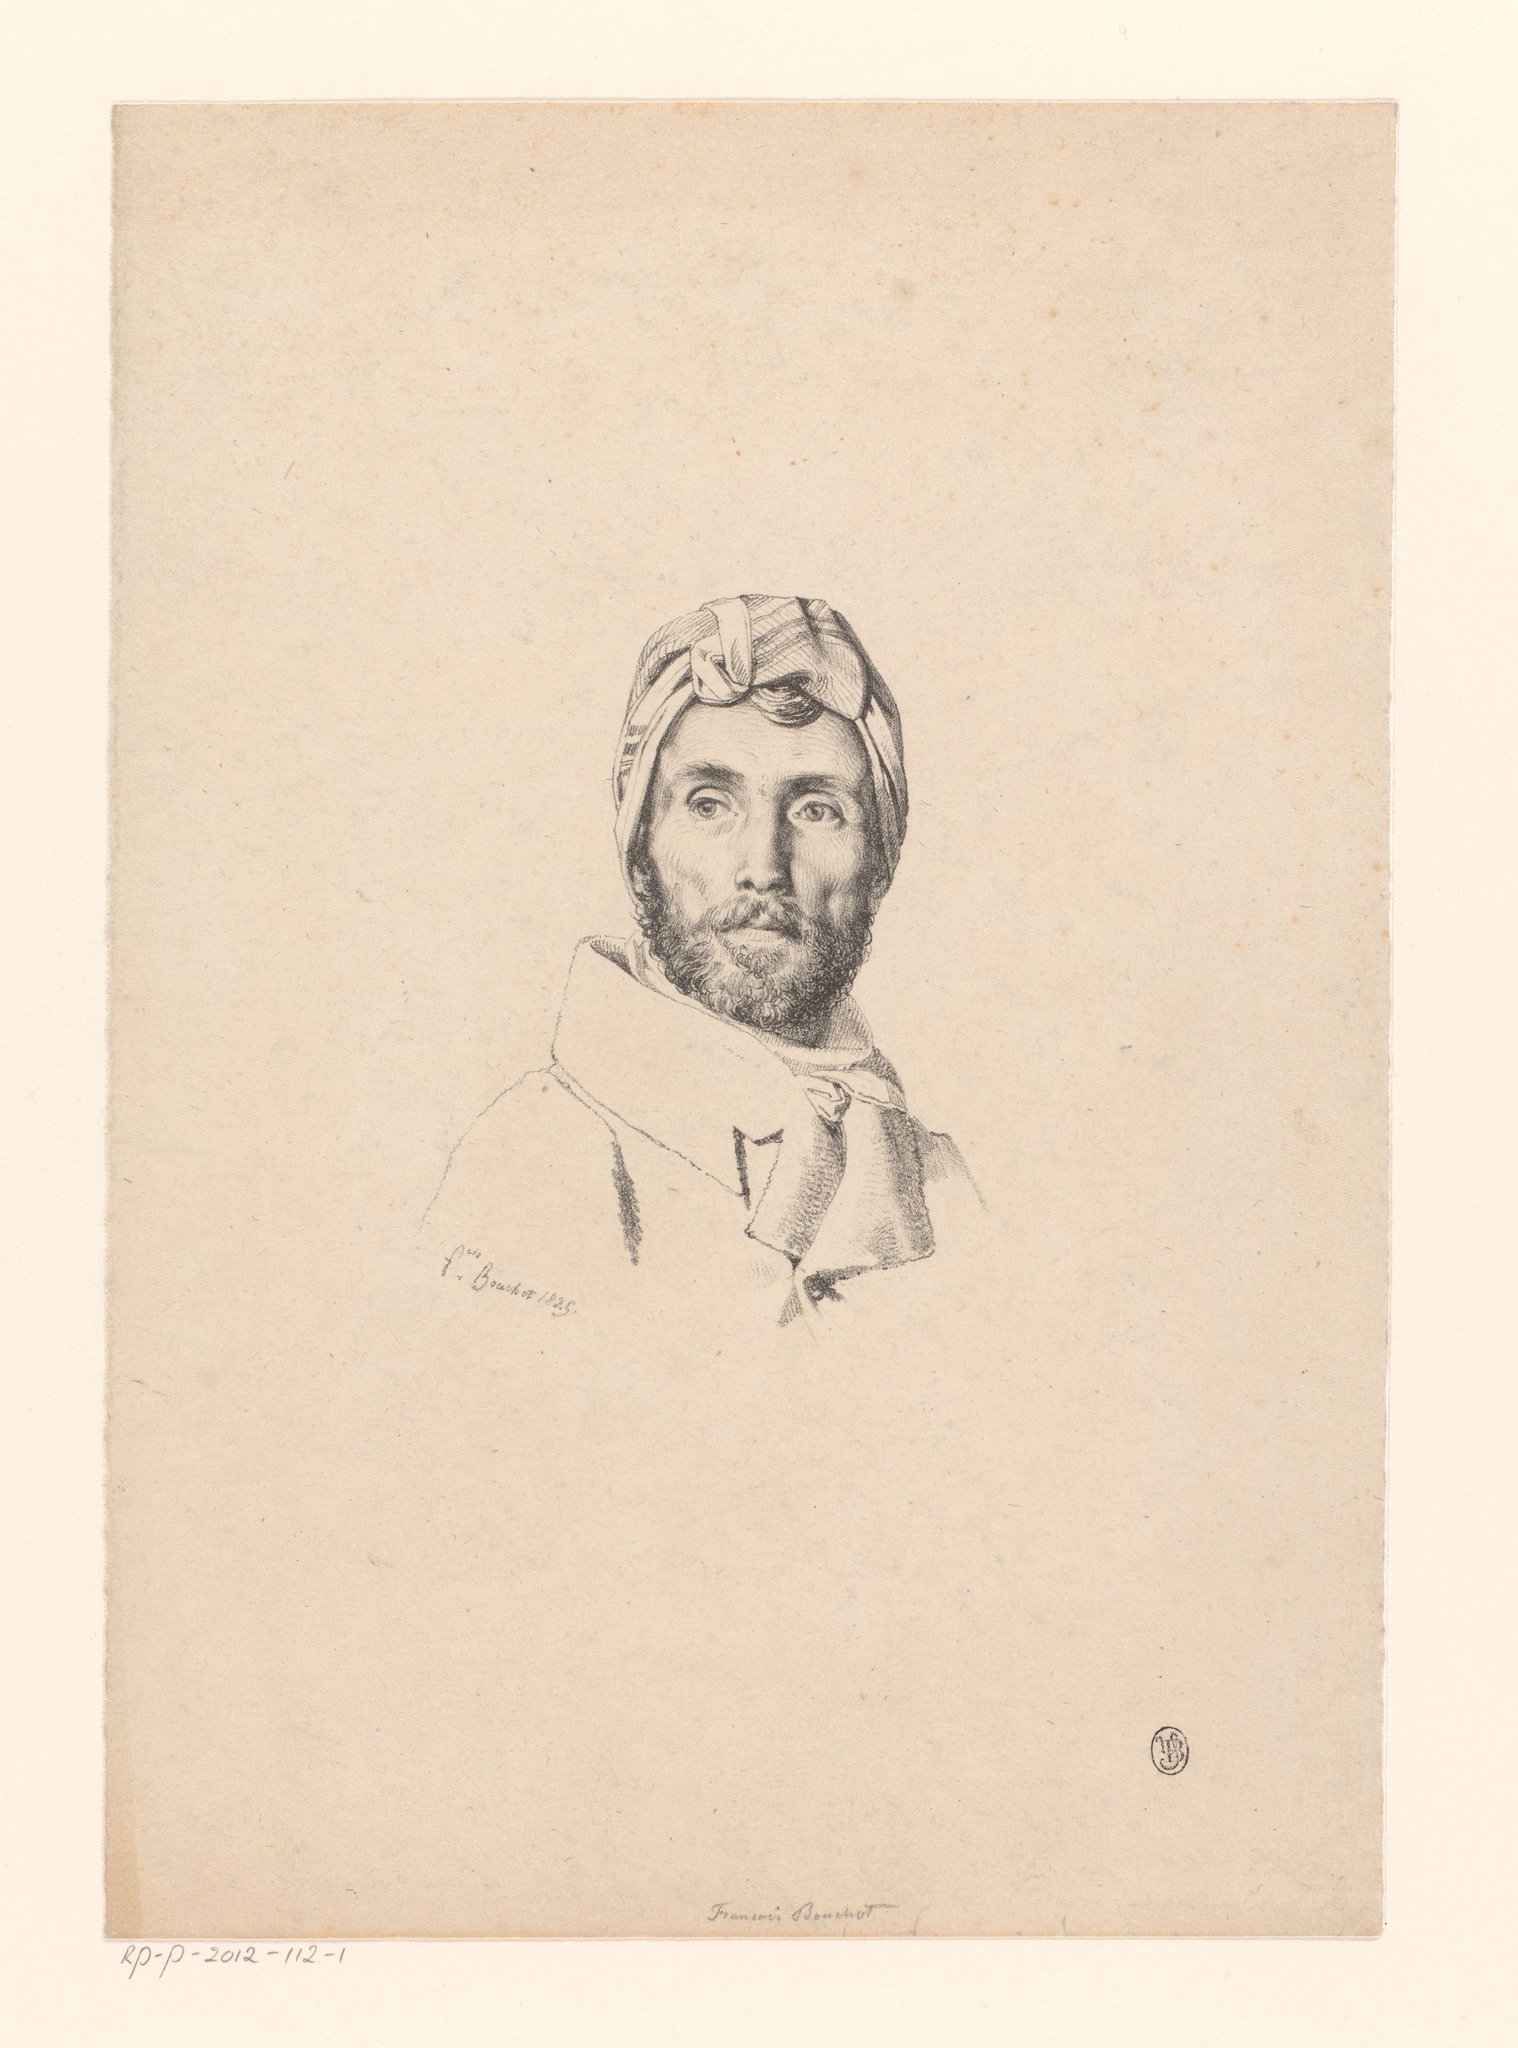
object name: print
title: Portret van de kunstenaar Pierre Narcisse Guérin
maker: françois bouchot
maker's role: painter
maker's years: 1800-1842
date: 1825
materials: paper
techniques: lithograph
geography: paris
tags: paris, rome, print maker, draughtsman, pierre narcisse guérin, portrait, self-portrait of artist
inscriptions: number: ‘rfc 17315’, number: ‘9-45’, stamp: Lugt 421, collector's mark: Lugt 2228a